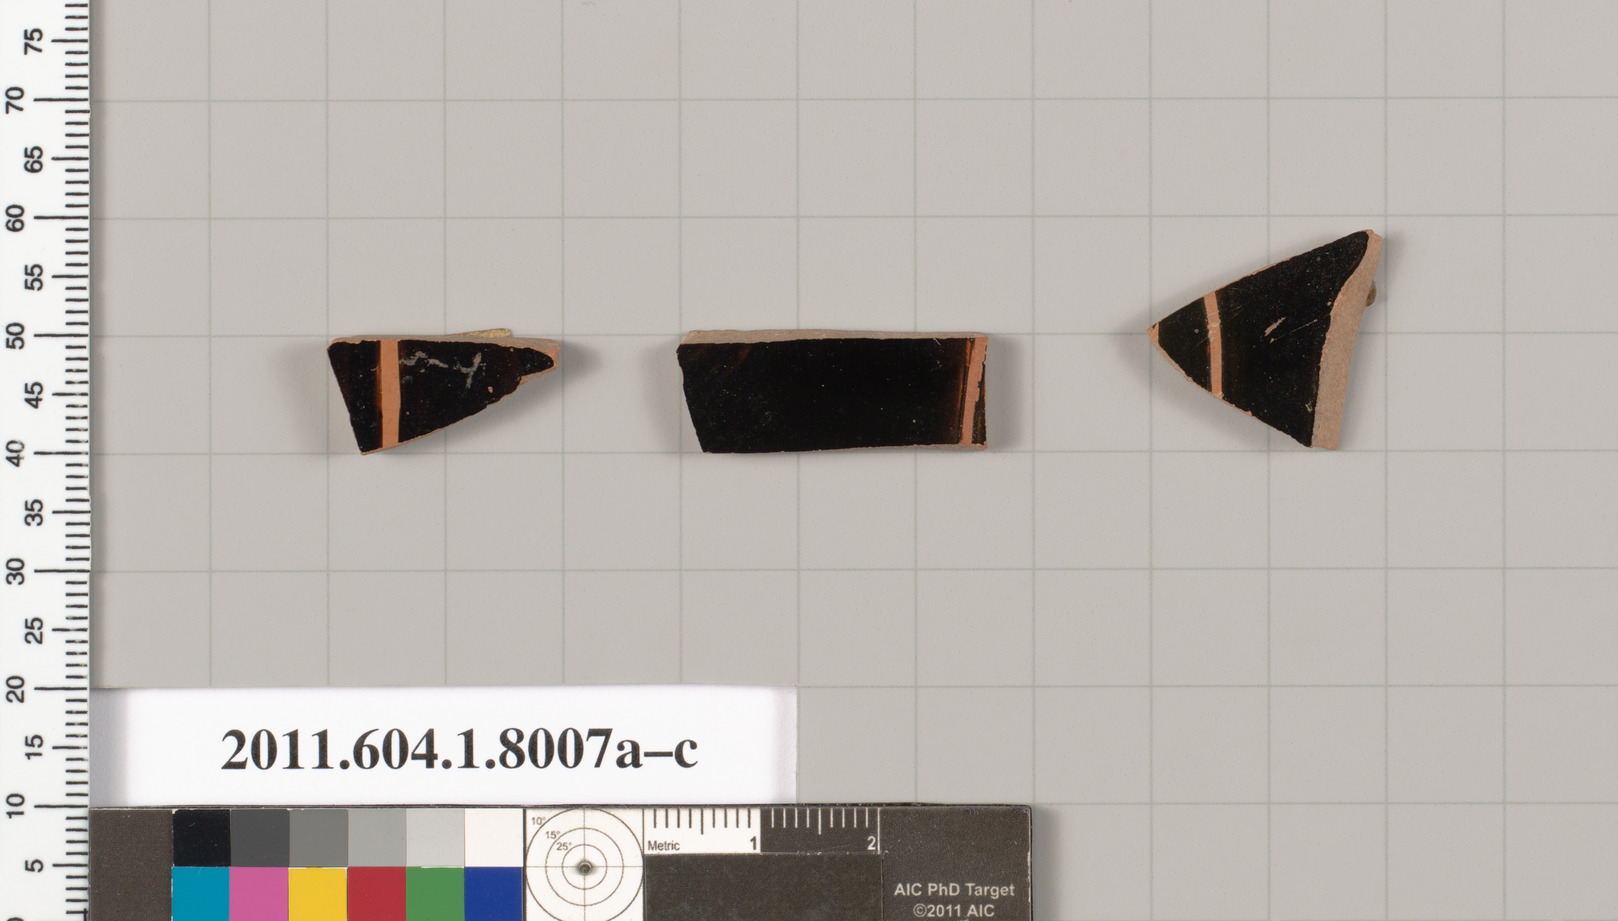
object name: kylix fragment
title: Terracotta fragments of kylikes (drinking cups)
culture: greek, attic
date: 460-450 BCE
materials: terracotta